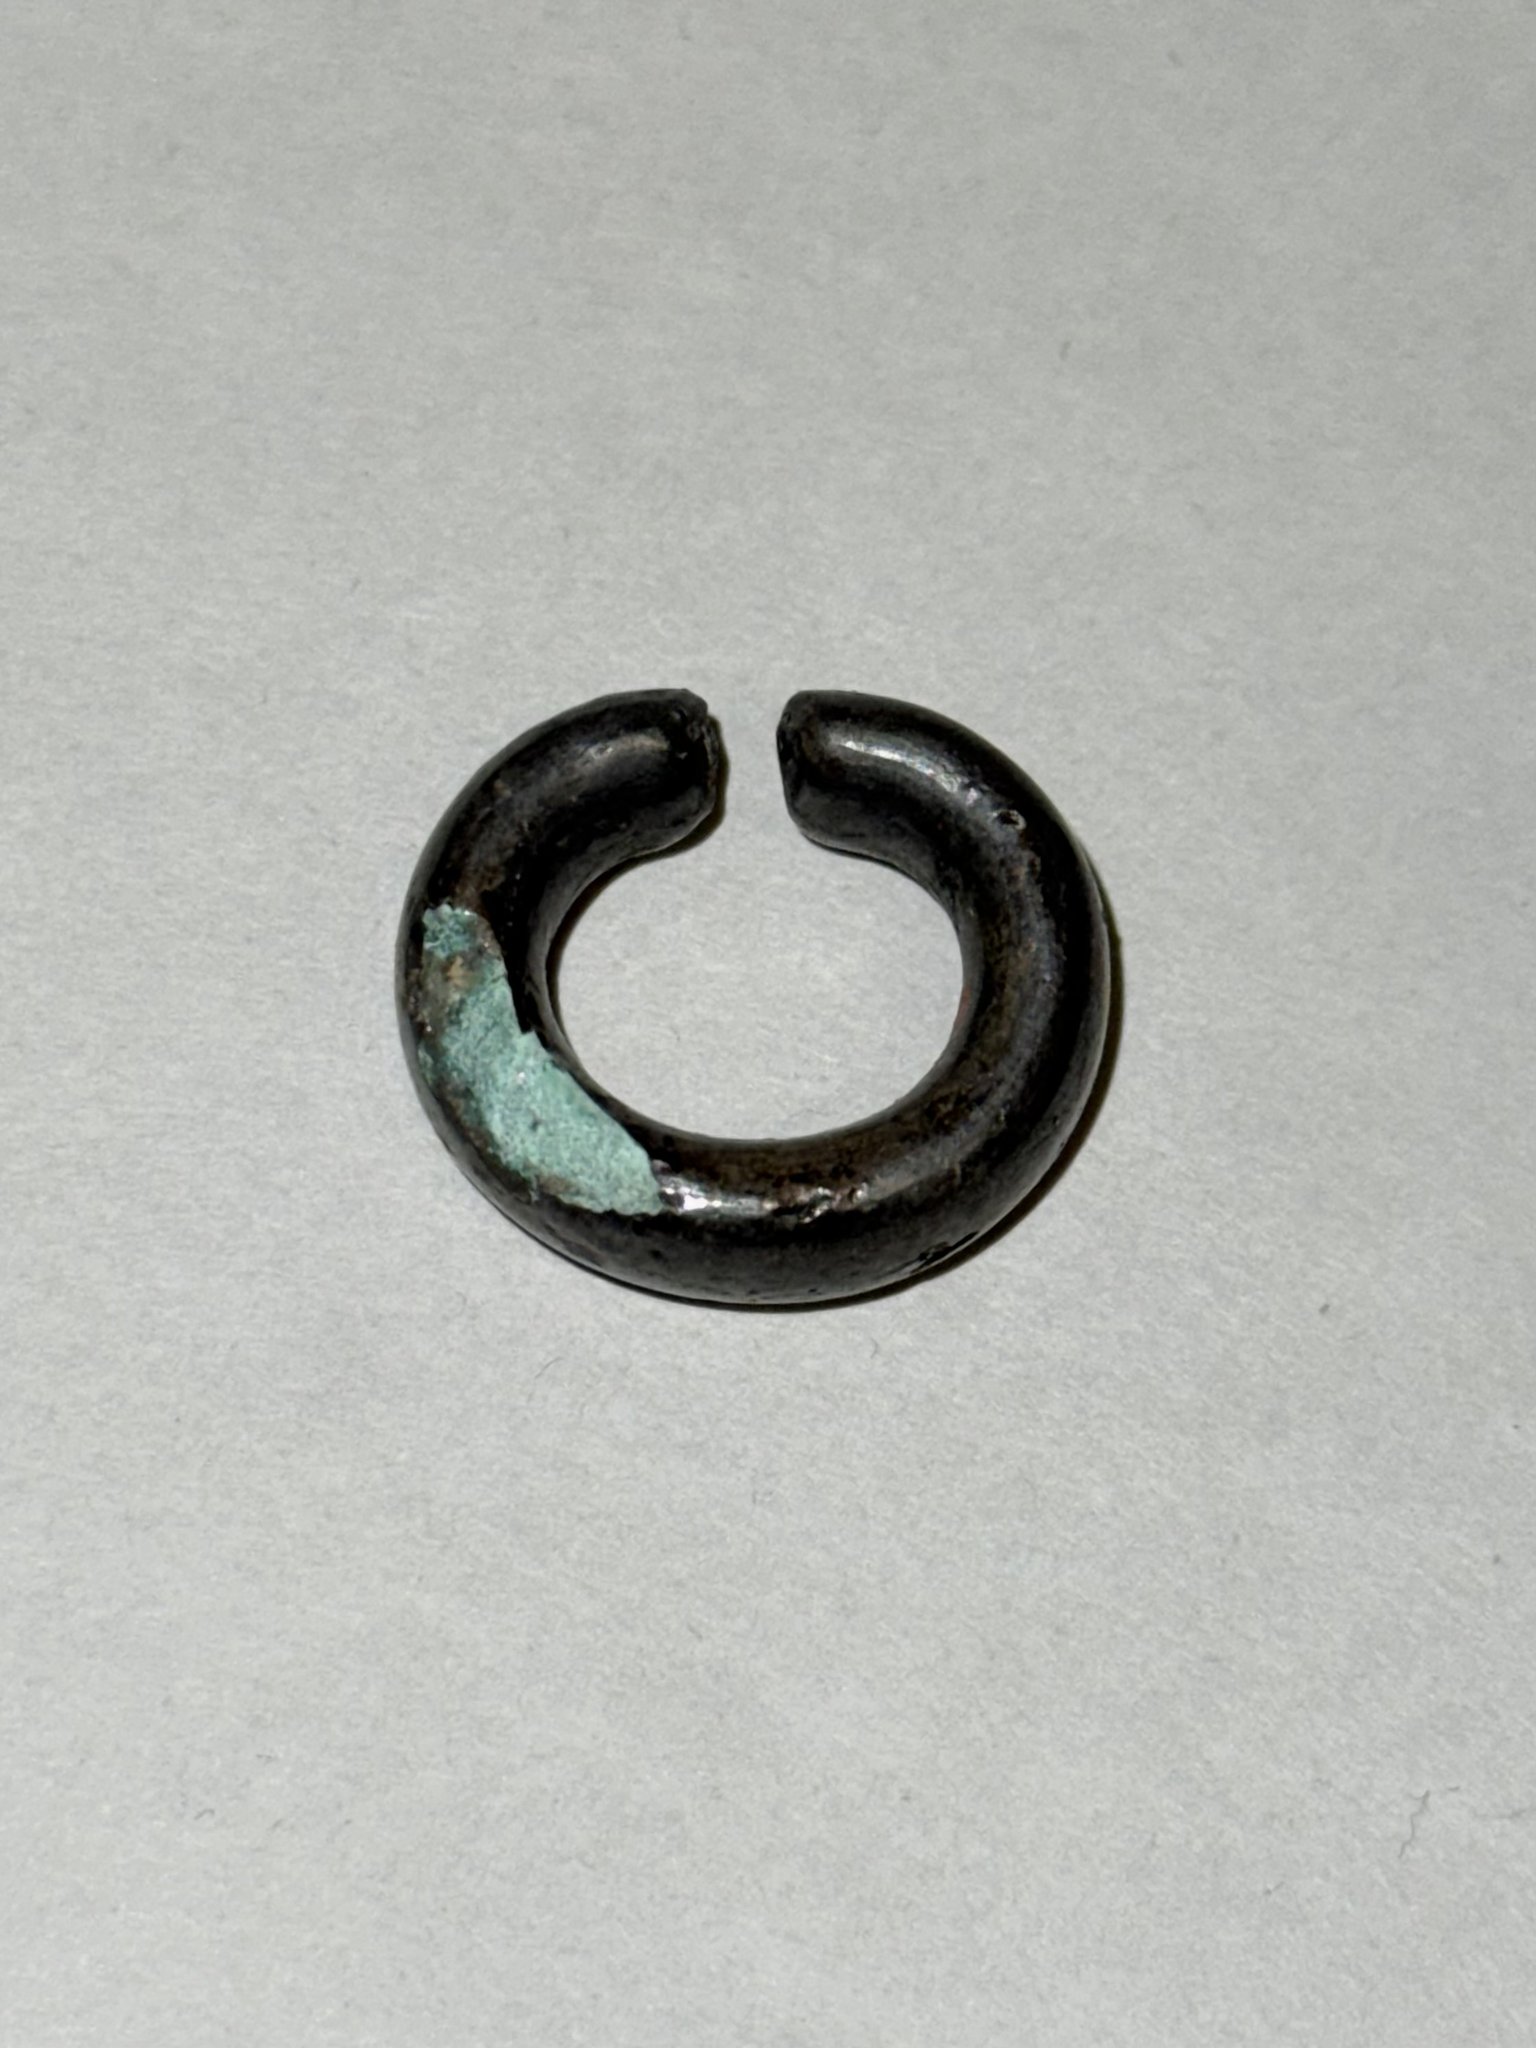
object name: earring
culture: japanese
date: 601-700